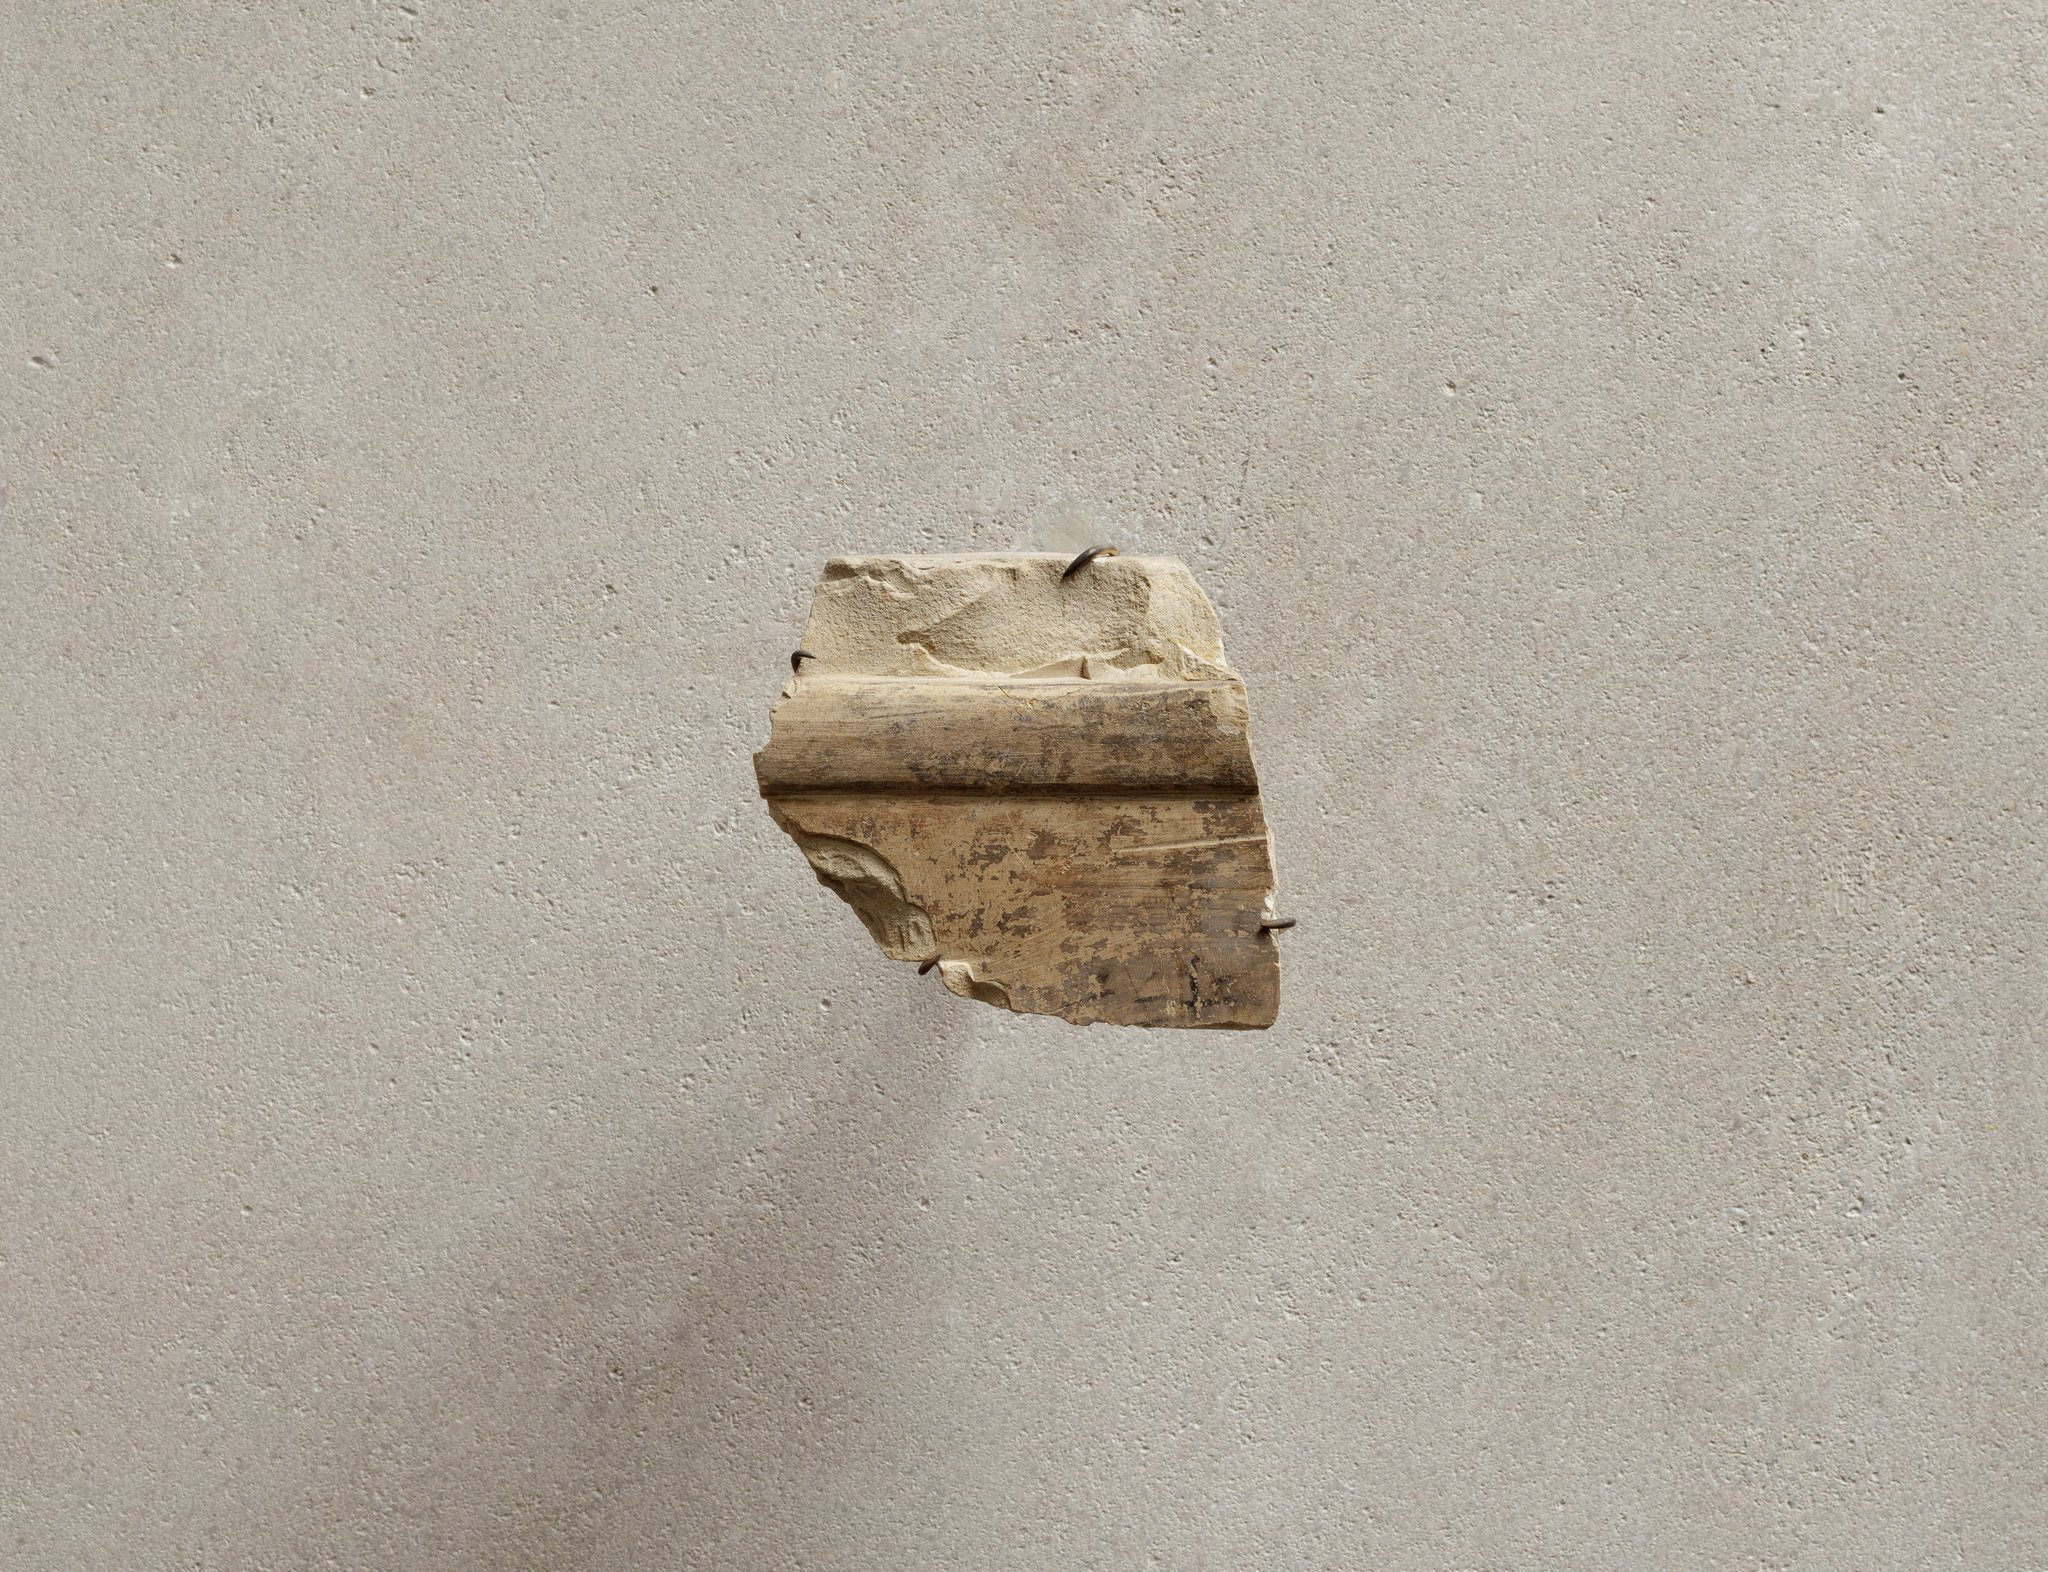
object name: relief fragment, neferu or khety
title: Relief from the tomb of Queen Neferu: the feet of an attendant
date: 2051-2030 BCE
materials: limestone, paint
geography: egypt